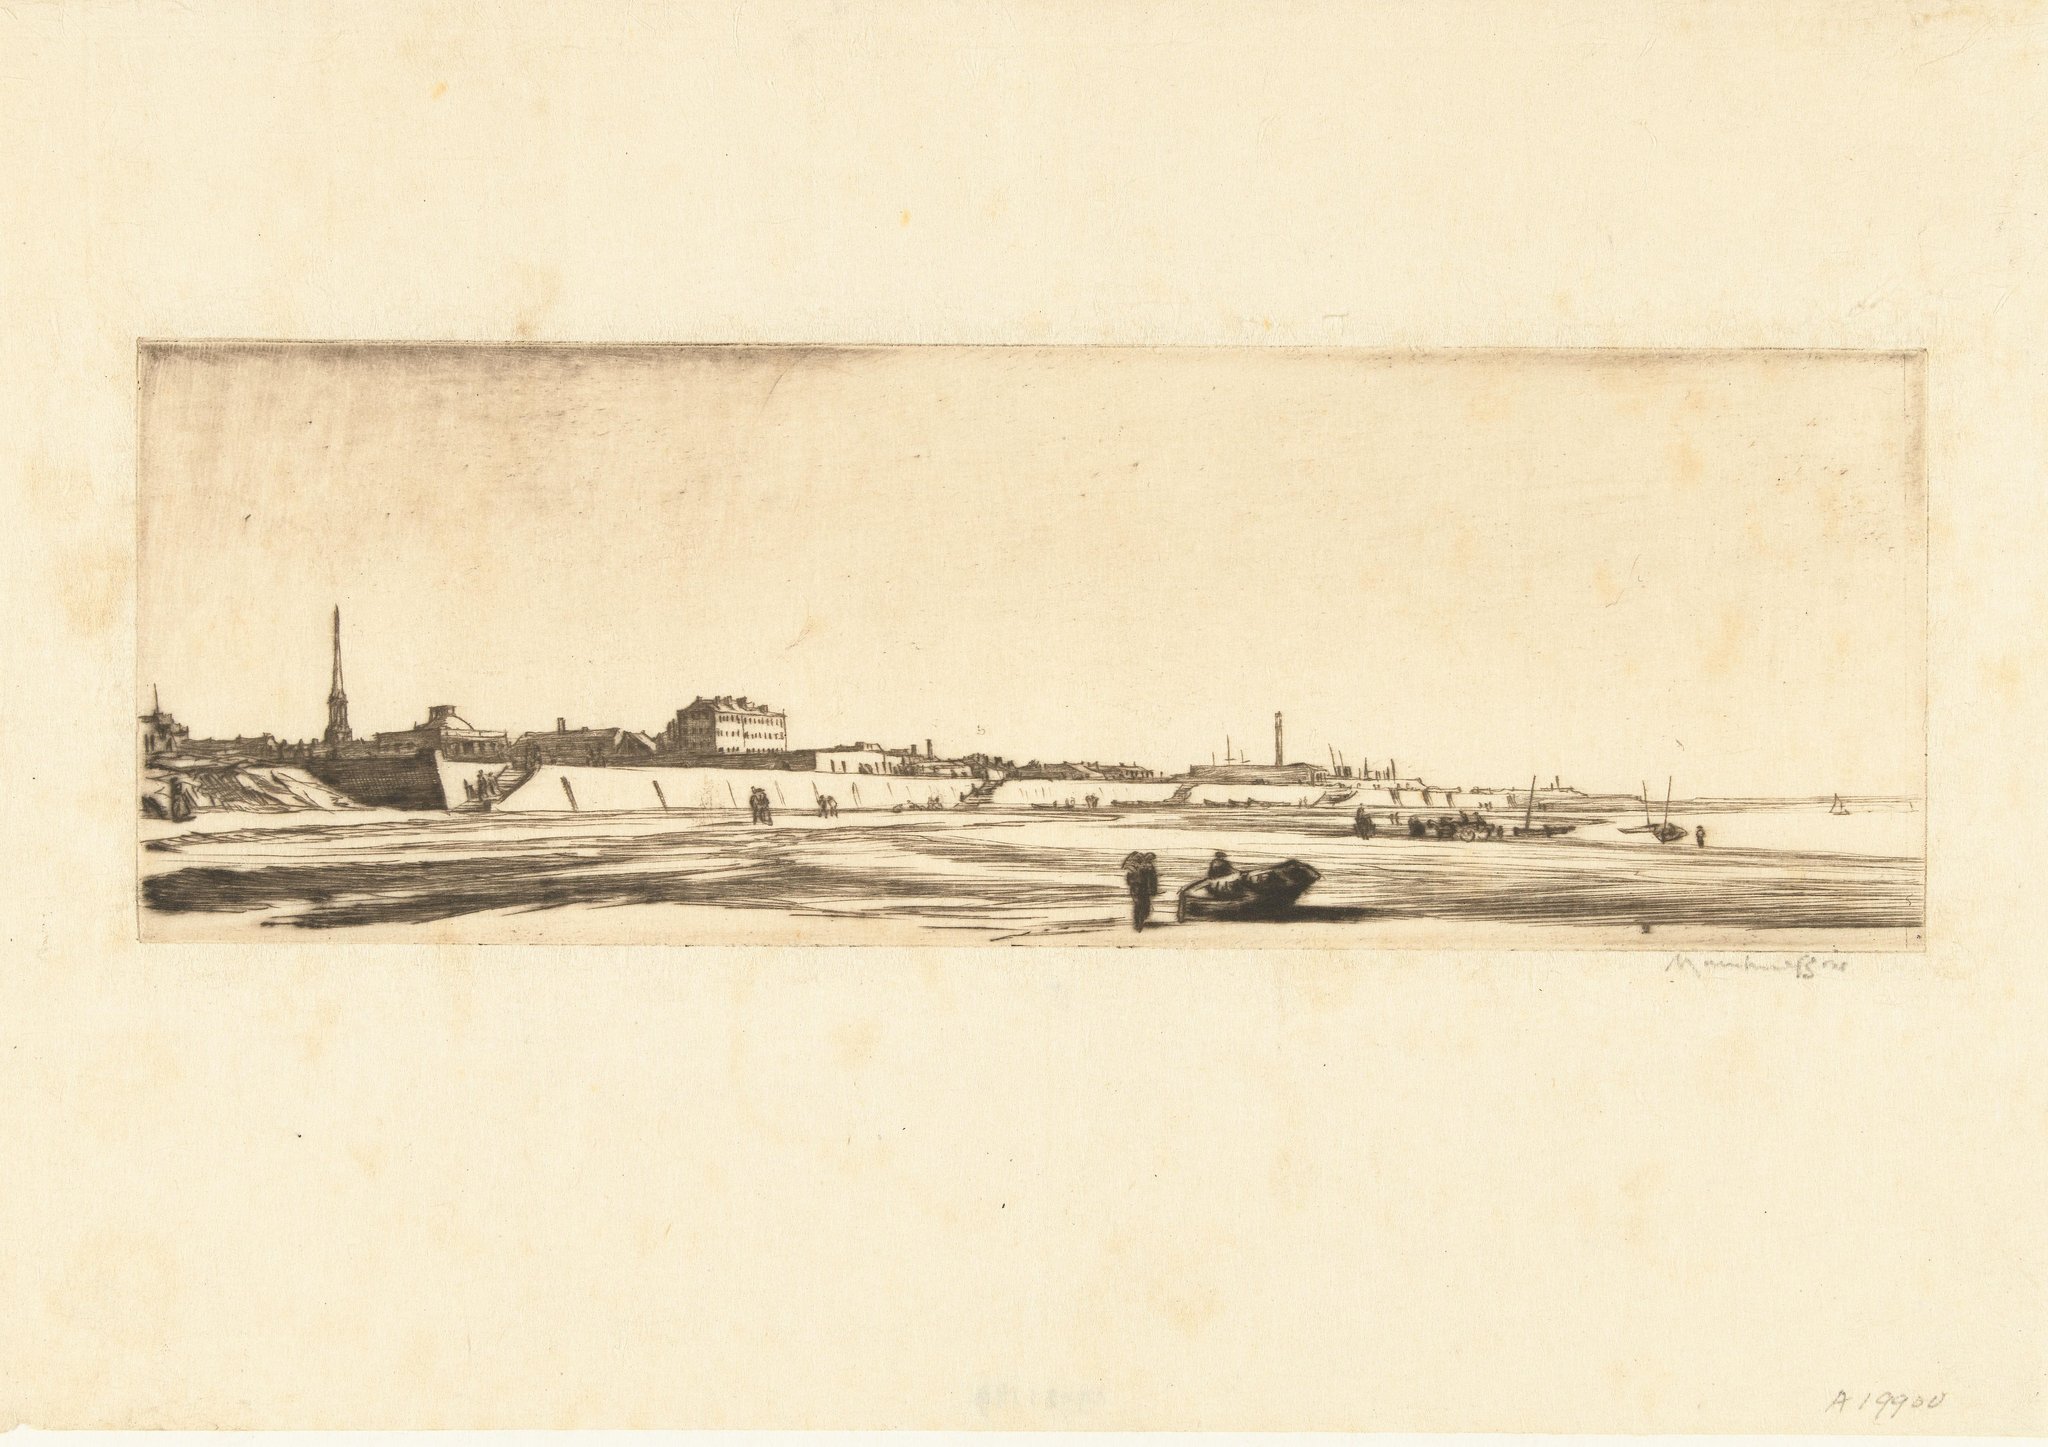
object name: print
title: Ayr Beach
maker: muirhead bone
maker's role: artist, print maker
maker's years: 1876-1953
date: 1909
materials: paper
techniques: drypoint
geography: england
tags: beach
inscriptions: signature: ‘Muirhead Bone’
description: Gezicht op een breed strand met een aantal mensen en boten. Achter de stenen kade het stadje Ayr.